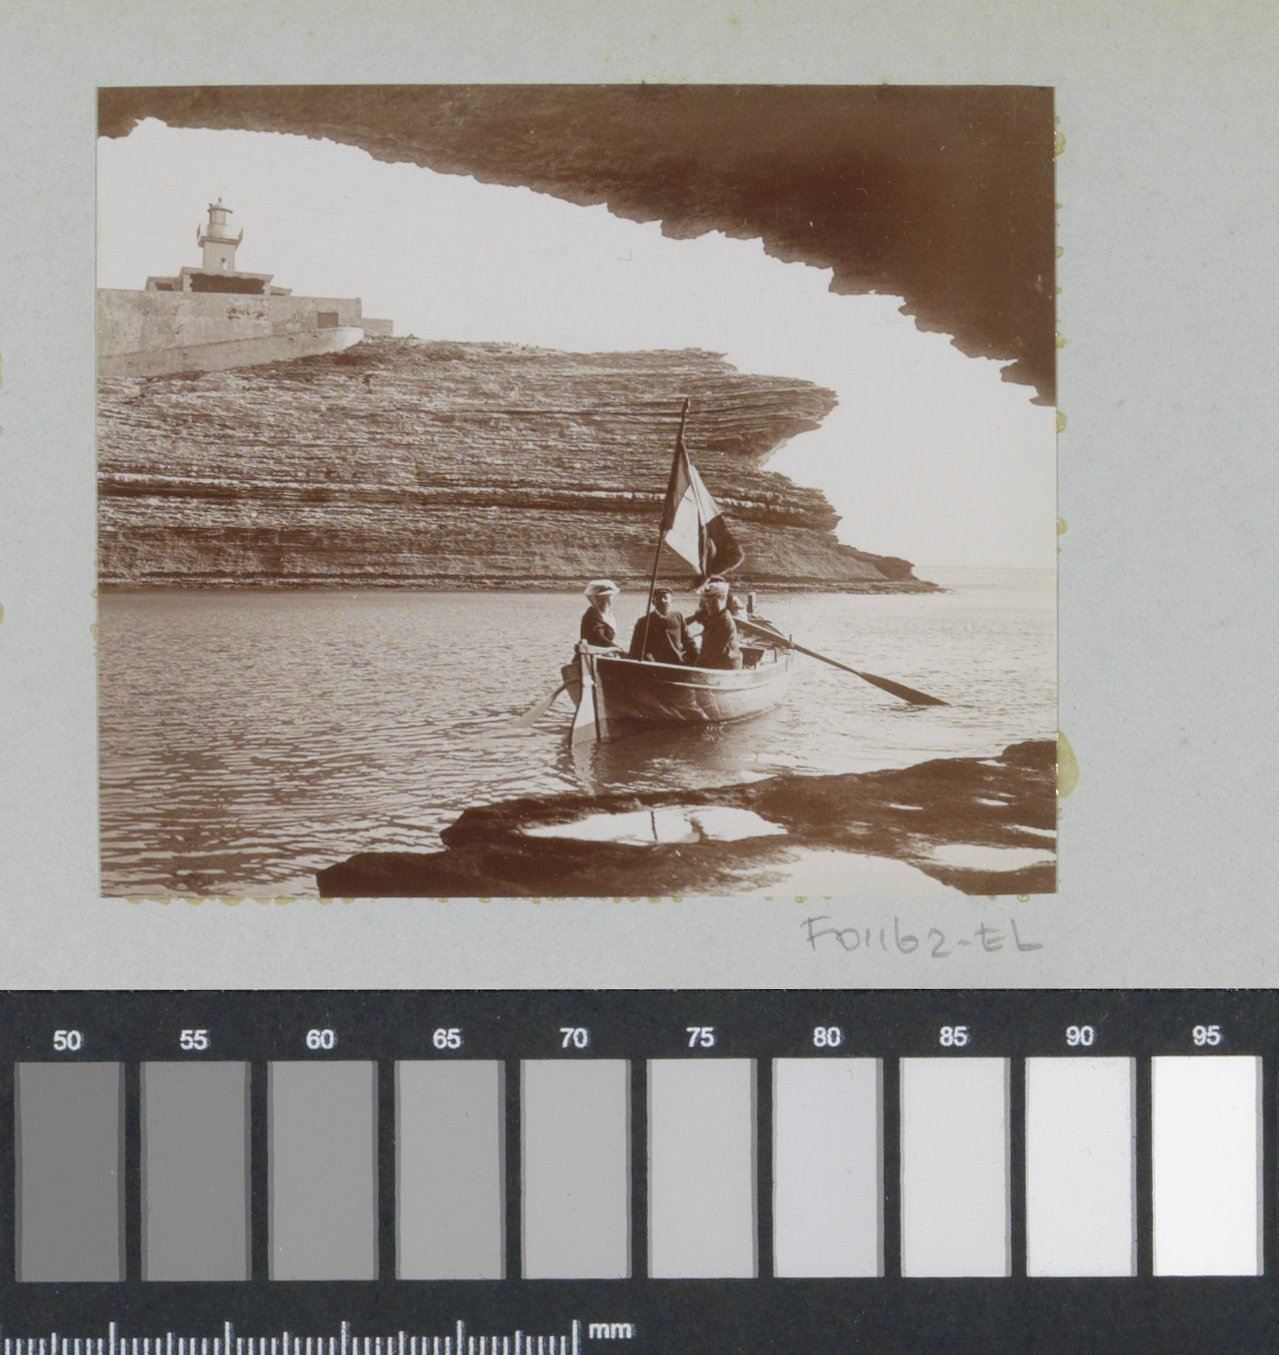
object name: photograph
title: Gezicht op de vuurtoren en de kliffen bij Bonifacio met op de voorgrond een gezelschap in een roeiboot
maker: Anonymous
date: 1905-1910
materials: paper, photographic support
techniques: gelatin silver print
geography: corsica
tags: lighthouse, lightship, rowing-boat, canoe, etc., coastal cliff or crag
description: Onderdeel van Fotoalbum van een Franse amateurfotograaf met bezienswaardigheden in Frankrijk, Zwitserland en Italië.